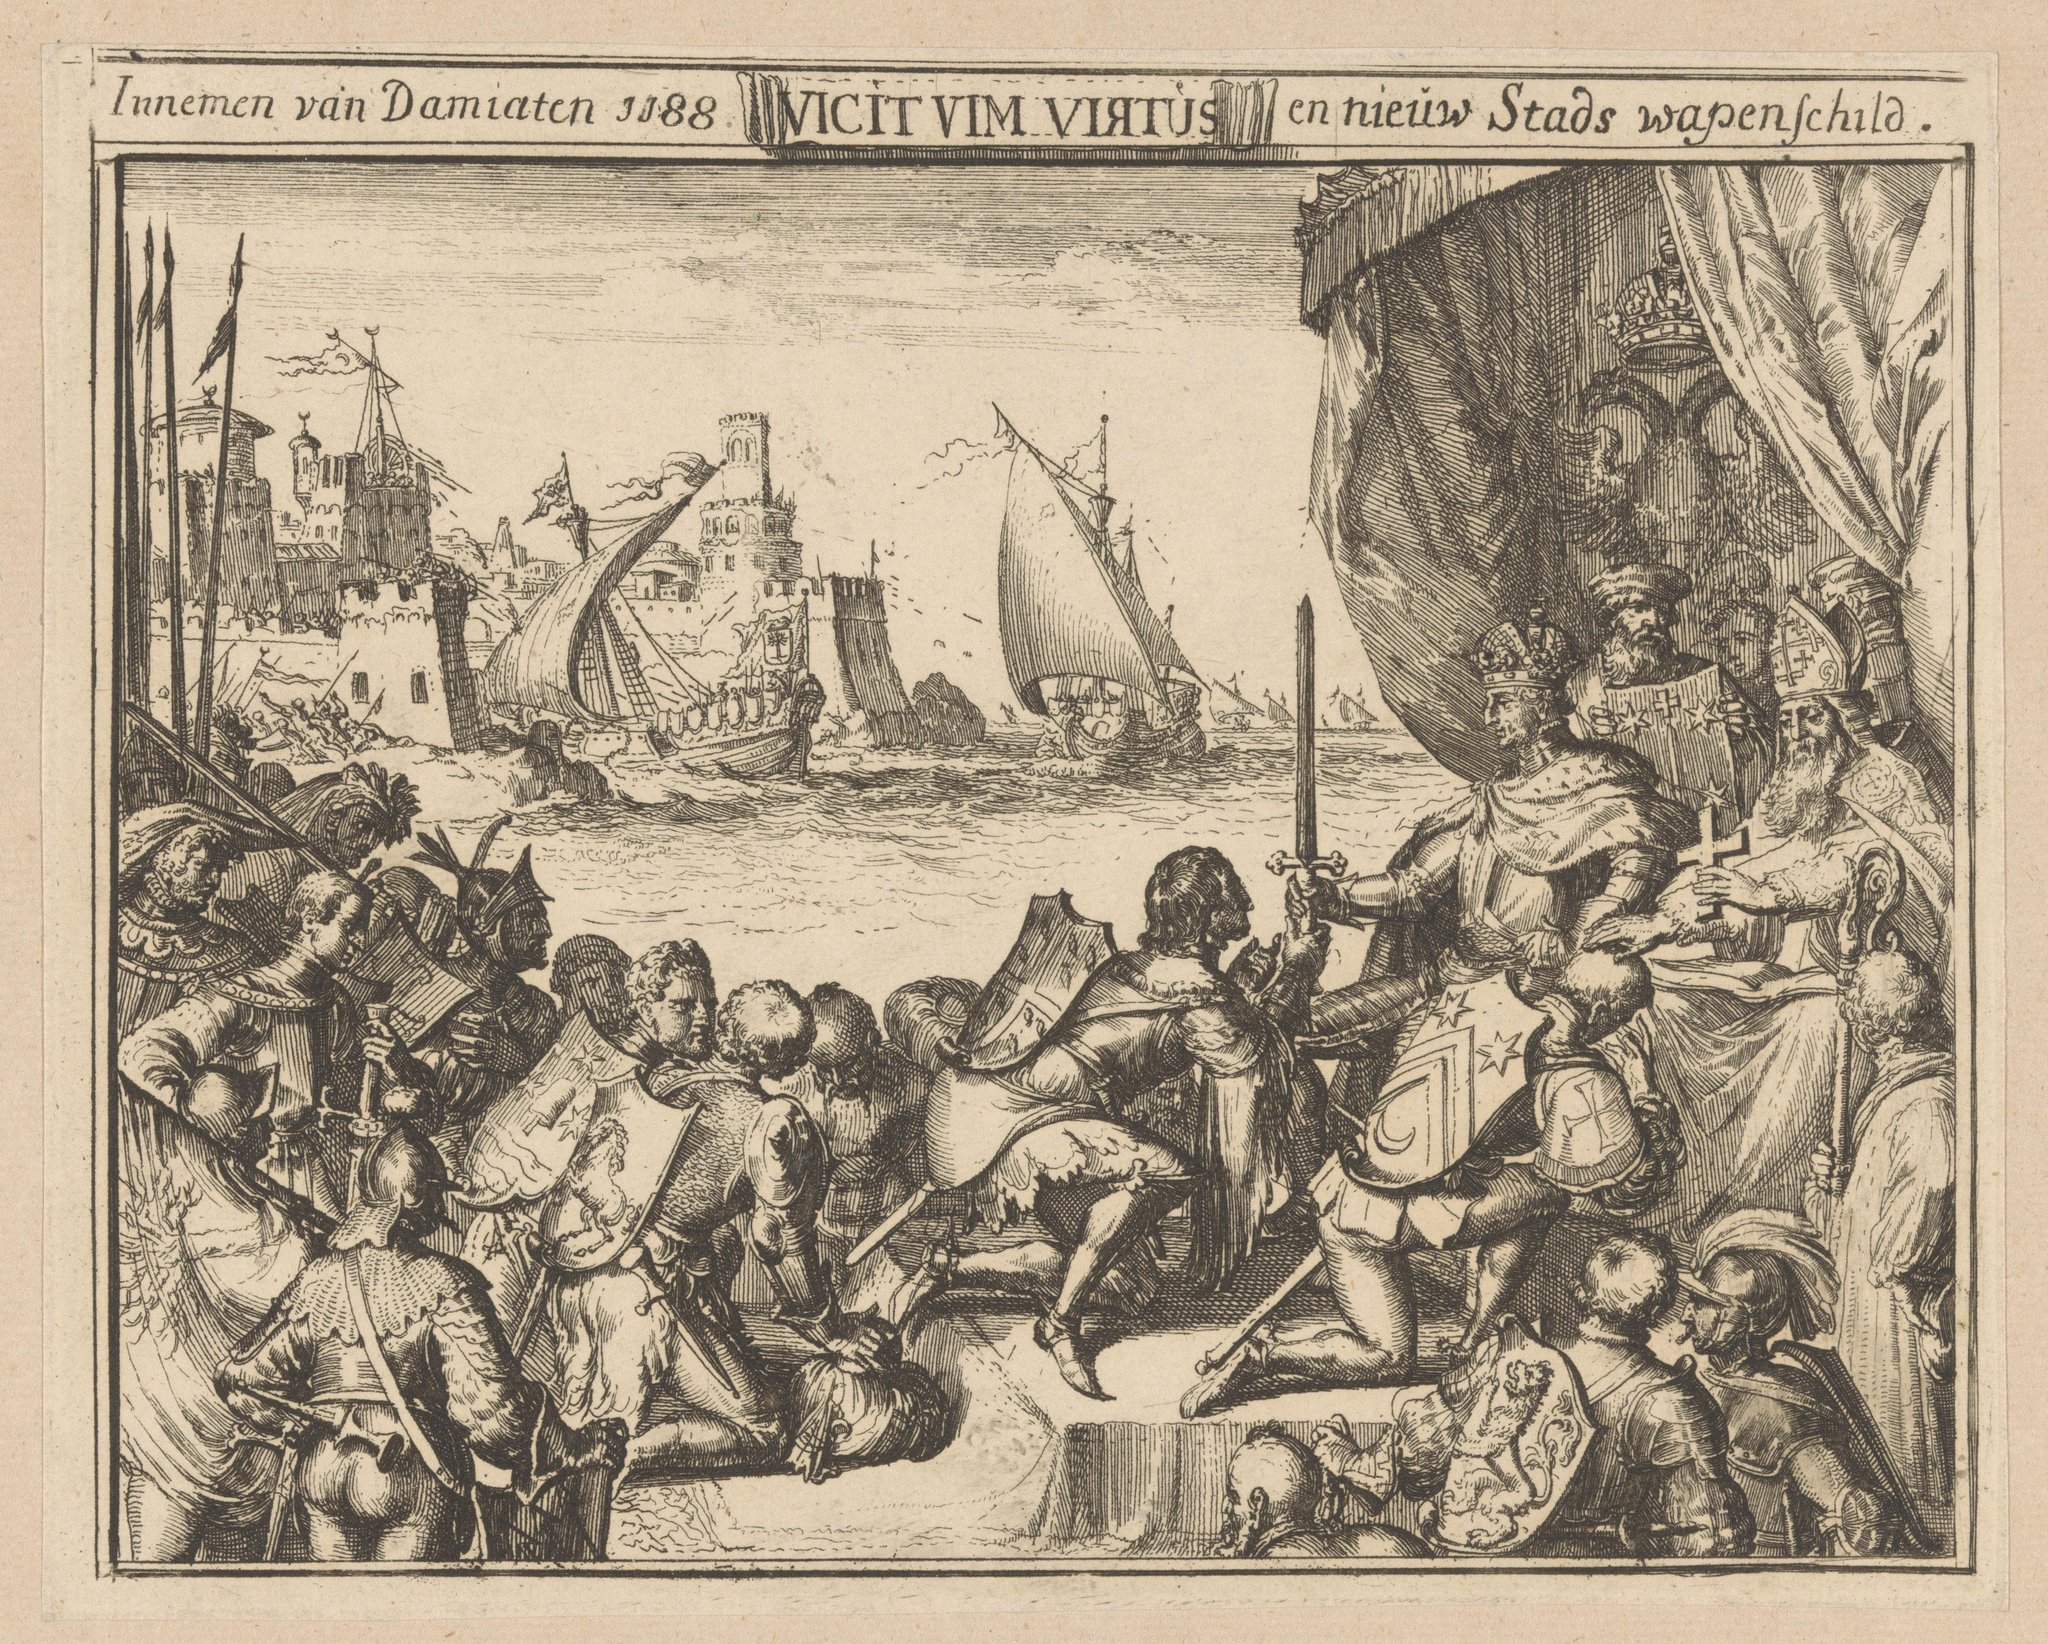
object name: history print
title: Innemen van Damiaten 1188 en nieuw stads wapenschild / Vicit vim virtus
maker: romeyn de hooghe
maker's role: draughtsman, goldsmith, painter, print maker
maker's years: 1645-1708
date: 1688-1689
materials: paper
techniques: etching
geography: haarlem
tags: haarlem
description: Kruisridders geknield voor de keizer en de paus ontvangen van deze de zegen en een zwaard. Op de achtergrond de verovering van de stad Damiate met het doorvaren van de ketting van de haven, 1219. Deze prent is oorspronkelijk bedoeld als onderdeel van een omvangrijke prent met een grote plattegrond van Haarlem, omgeven door zeven wapenschilden, een profiel van de stad, gezichten op markante Haarlemse gebouwen en voorstellingen van belangrijke momenten uit de Haarlemse geschiedenis.